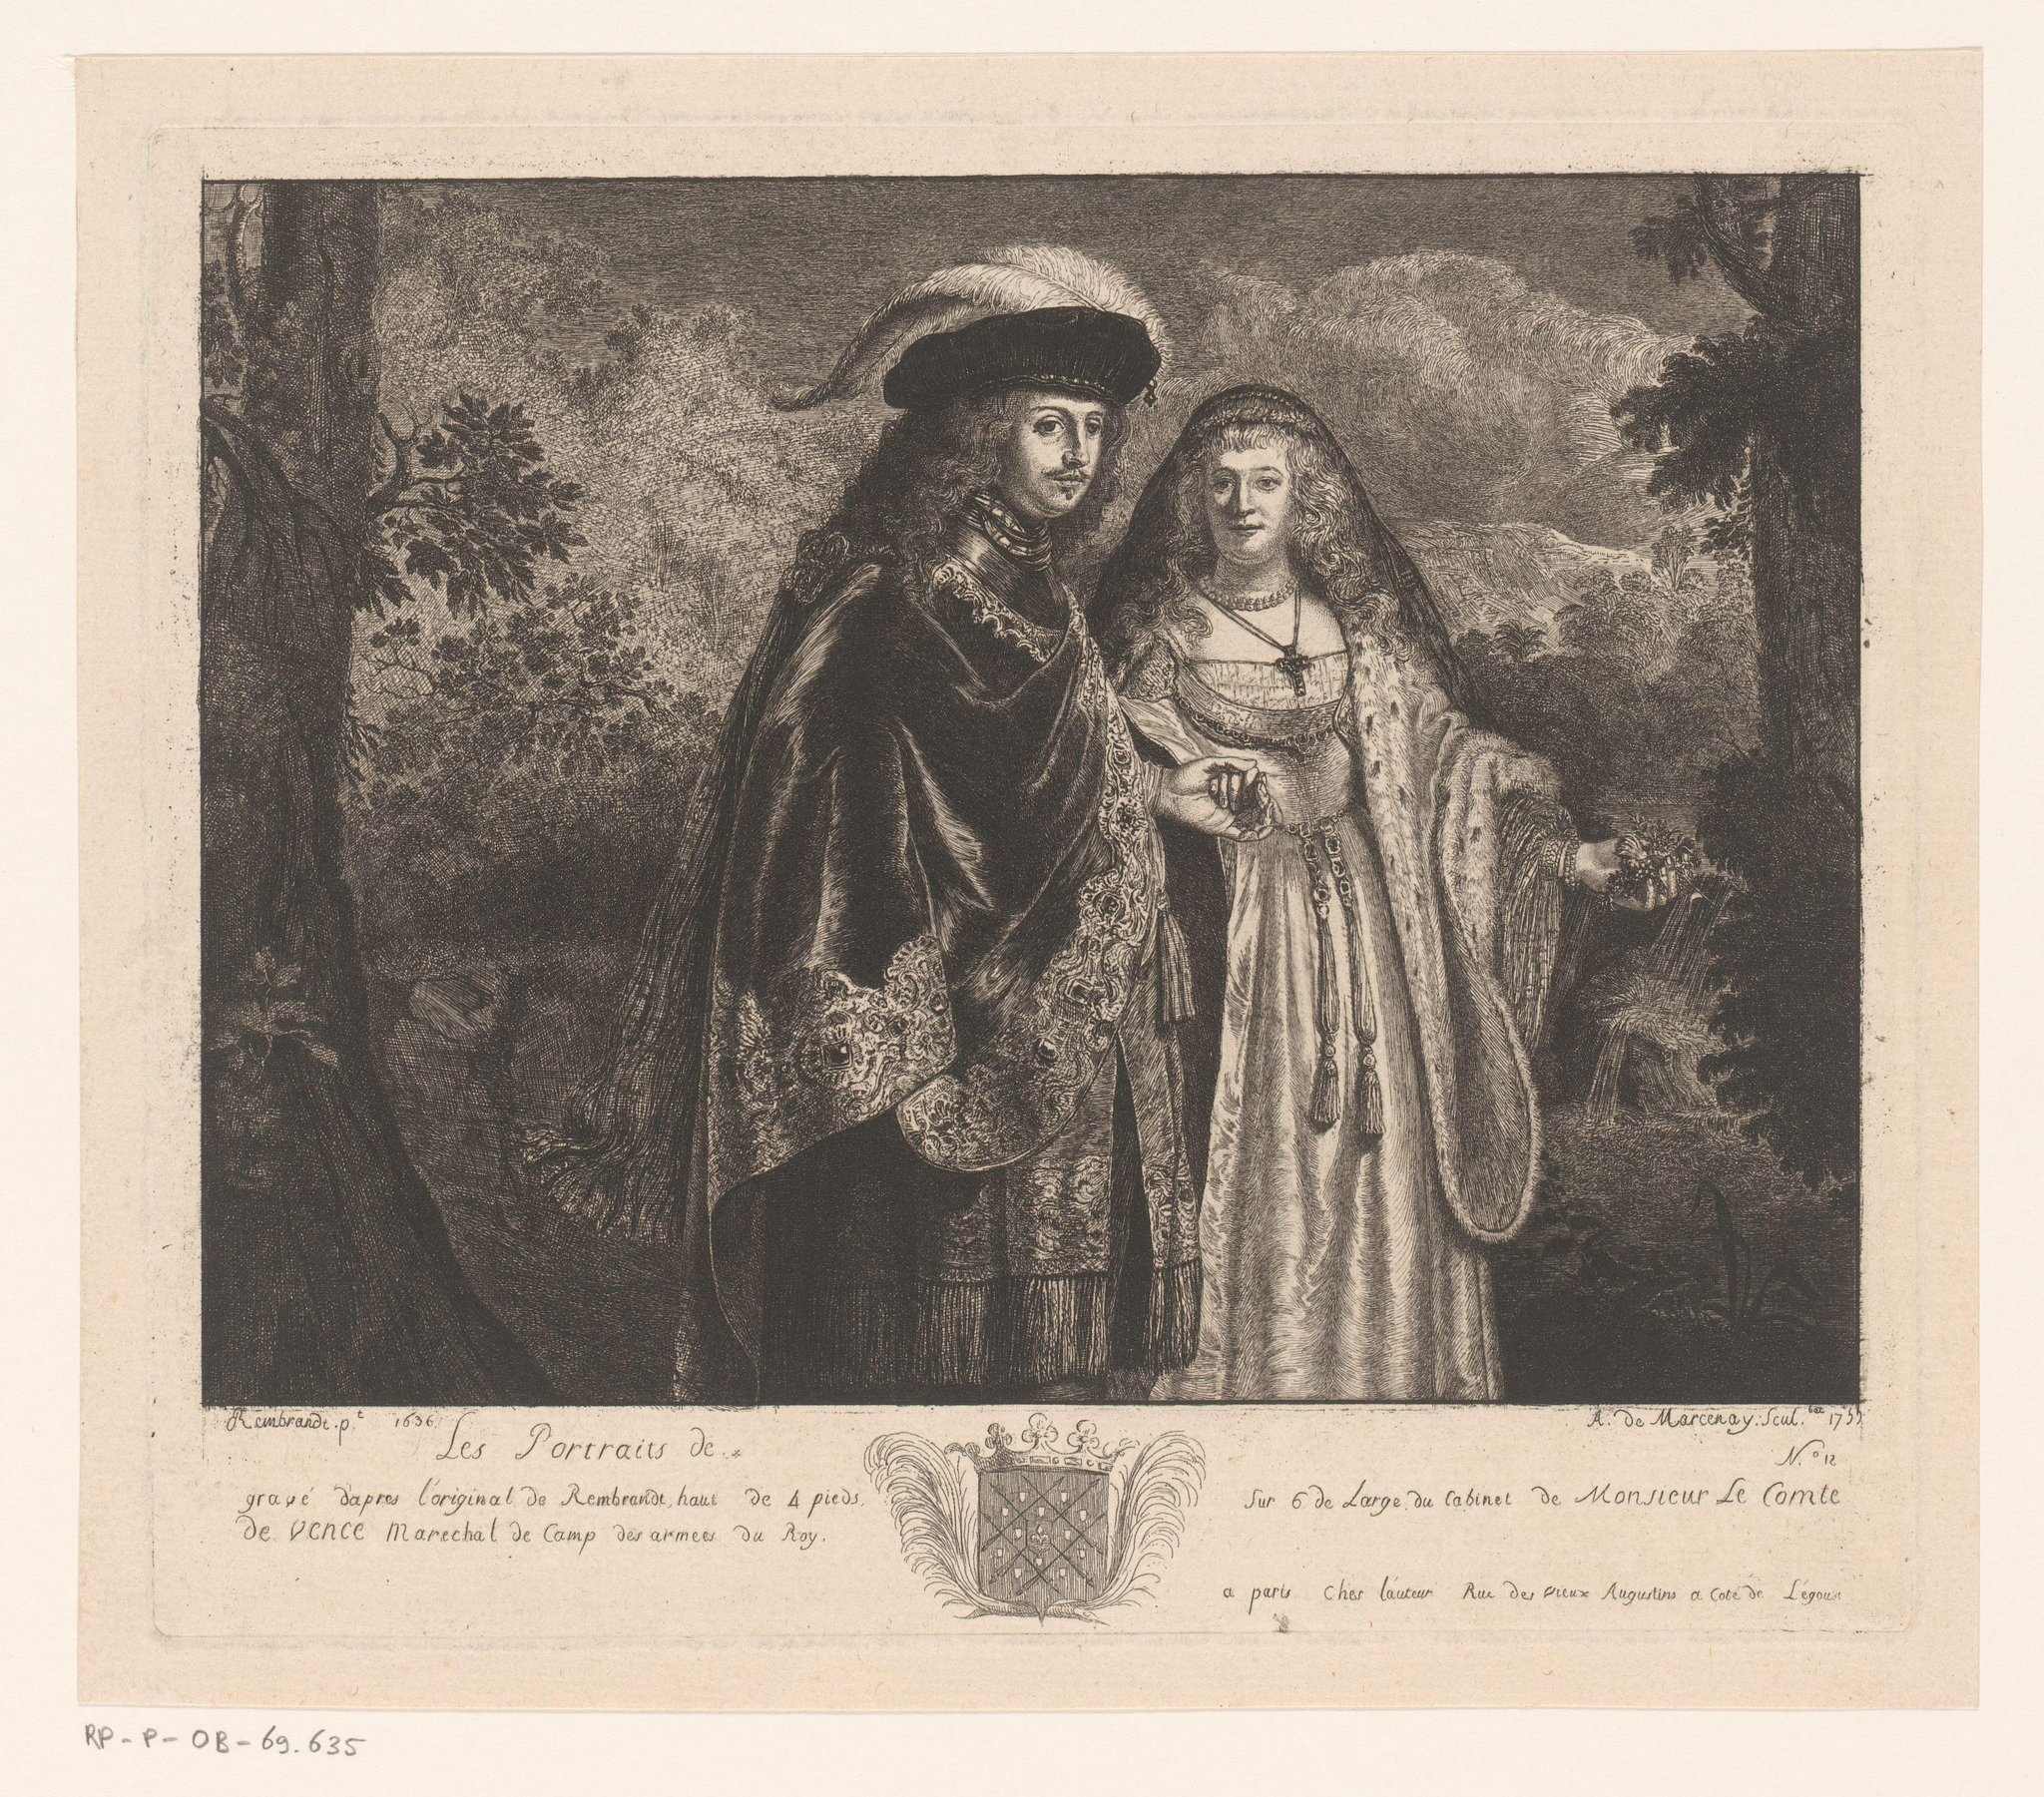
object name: print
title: Portret van een rijk gekleed echtpaar in een landschap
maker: antoine de marcenay de ghuy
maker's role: print maker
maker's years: 1724-1811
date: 1755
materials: paper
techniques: engraving, etching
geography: paris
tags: historical persons, marriage, married couple, 'matrimonium'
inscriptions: collector's mark: Lugt 2228